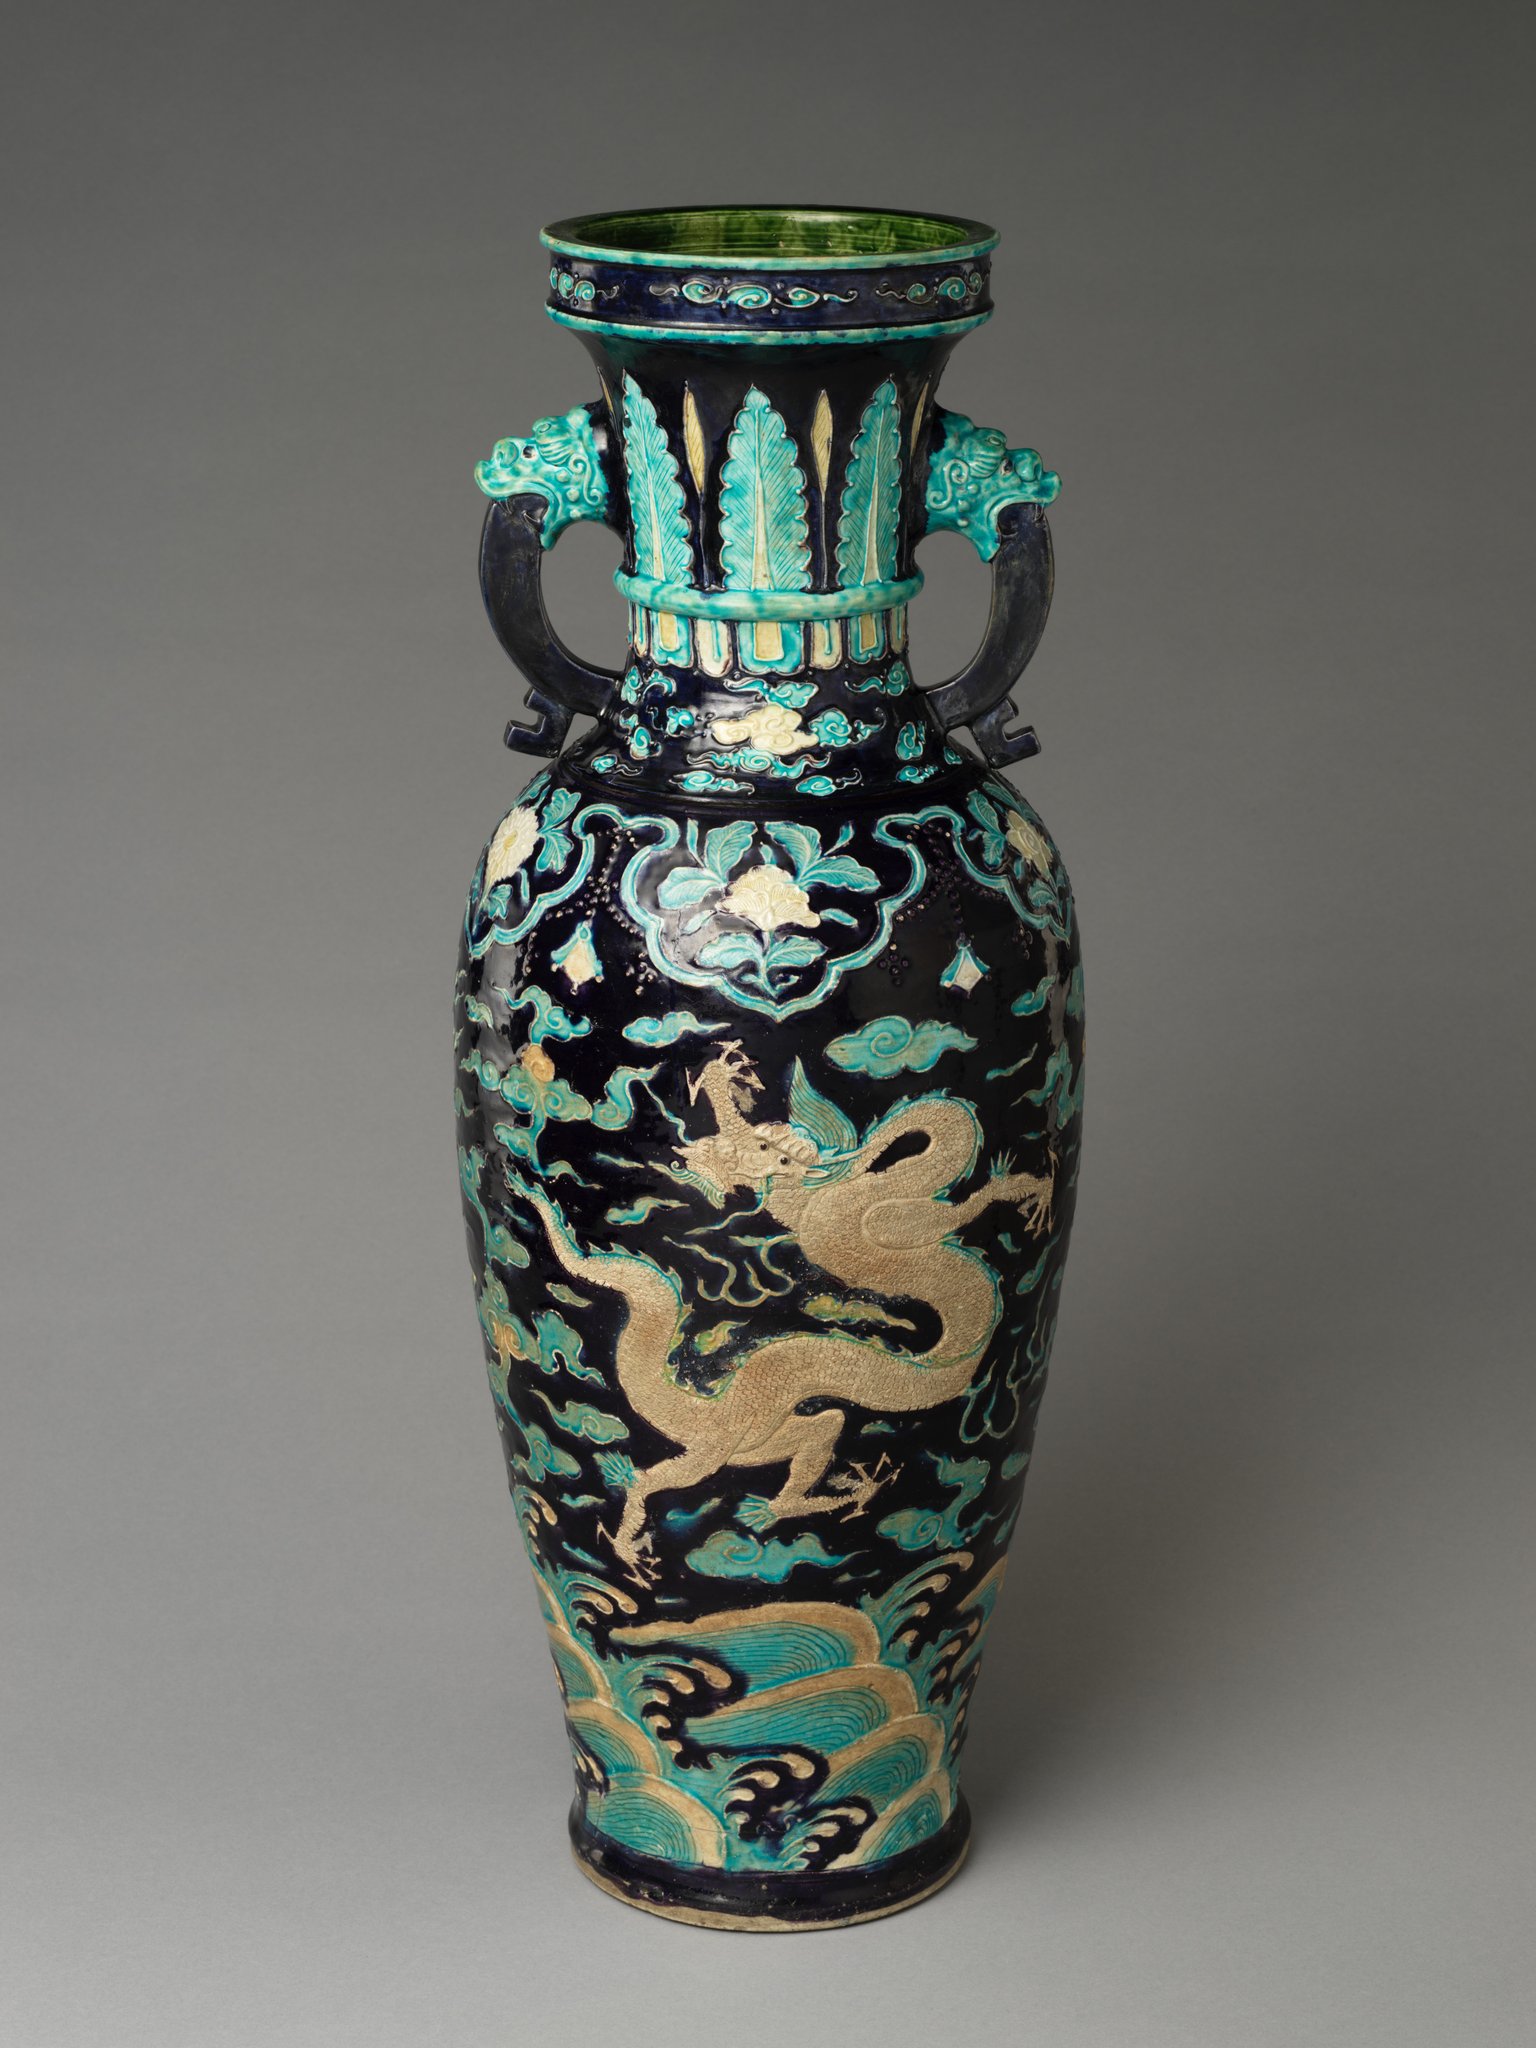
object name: vase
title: Temple vase with dragons and clouds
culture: chinese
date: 1501-1600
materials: enamel, porcelain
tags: dragons,clouds